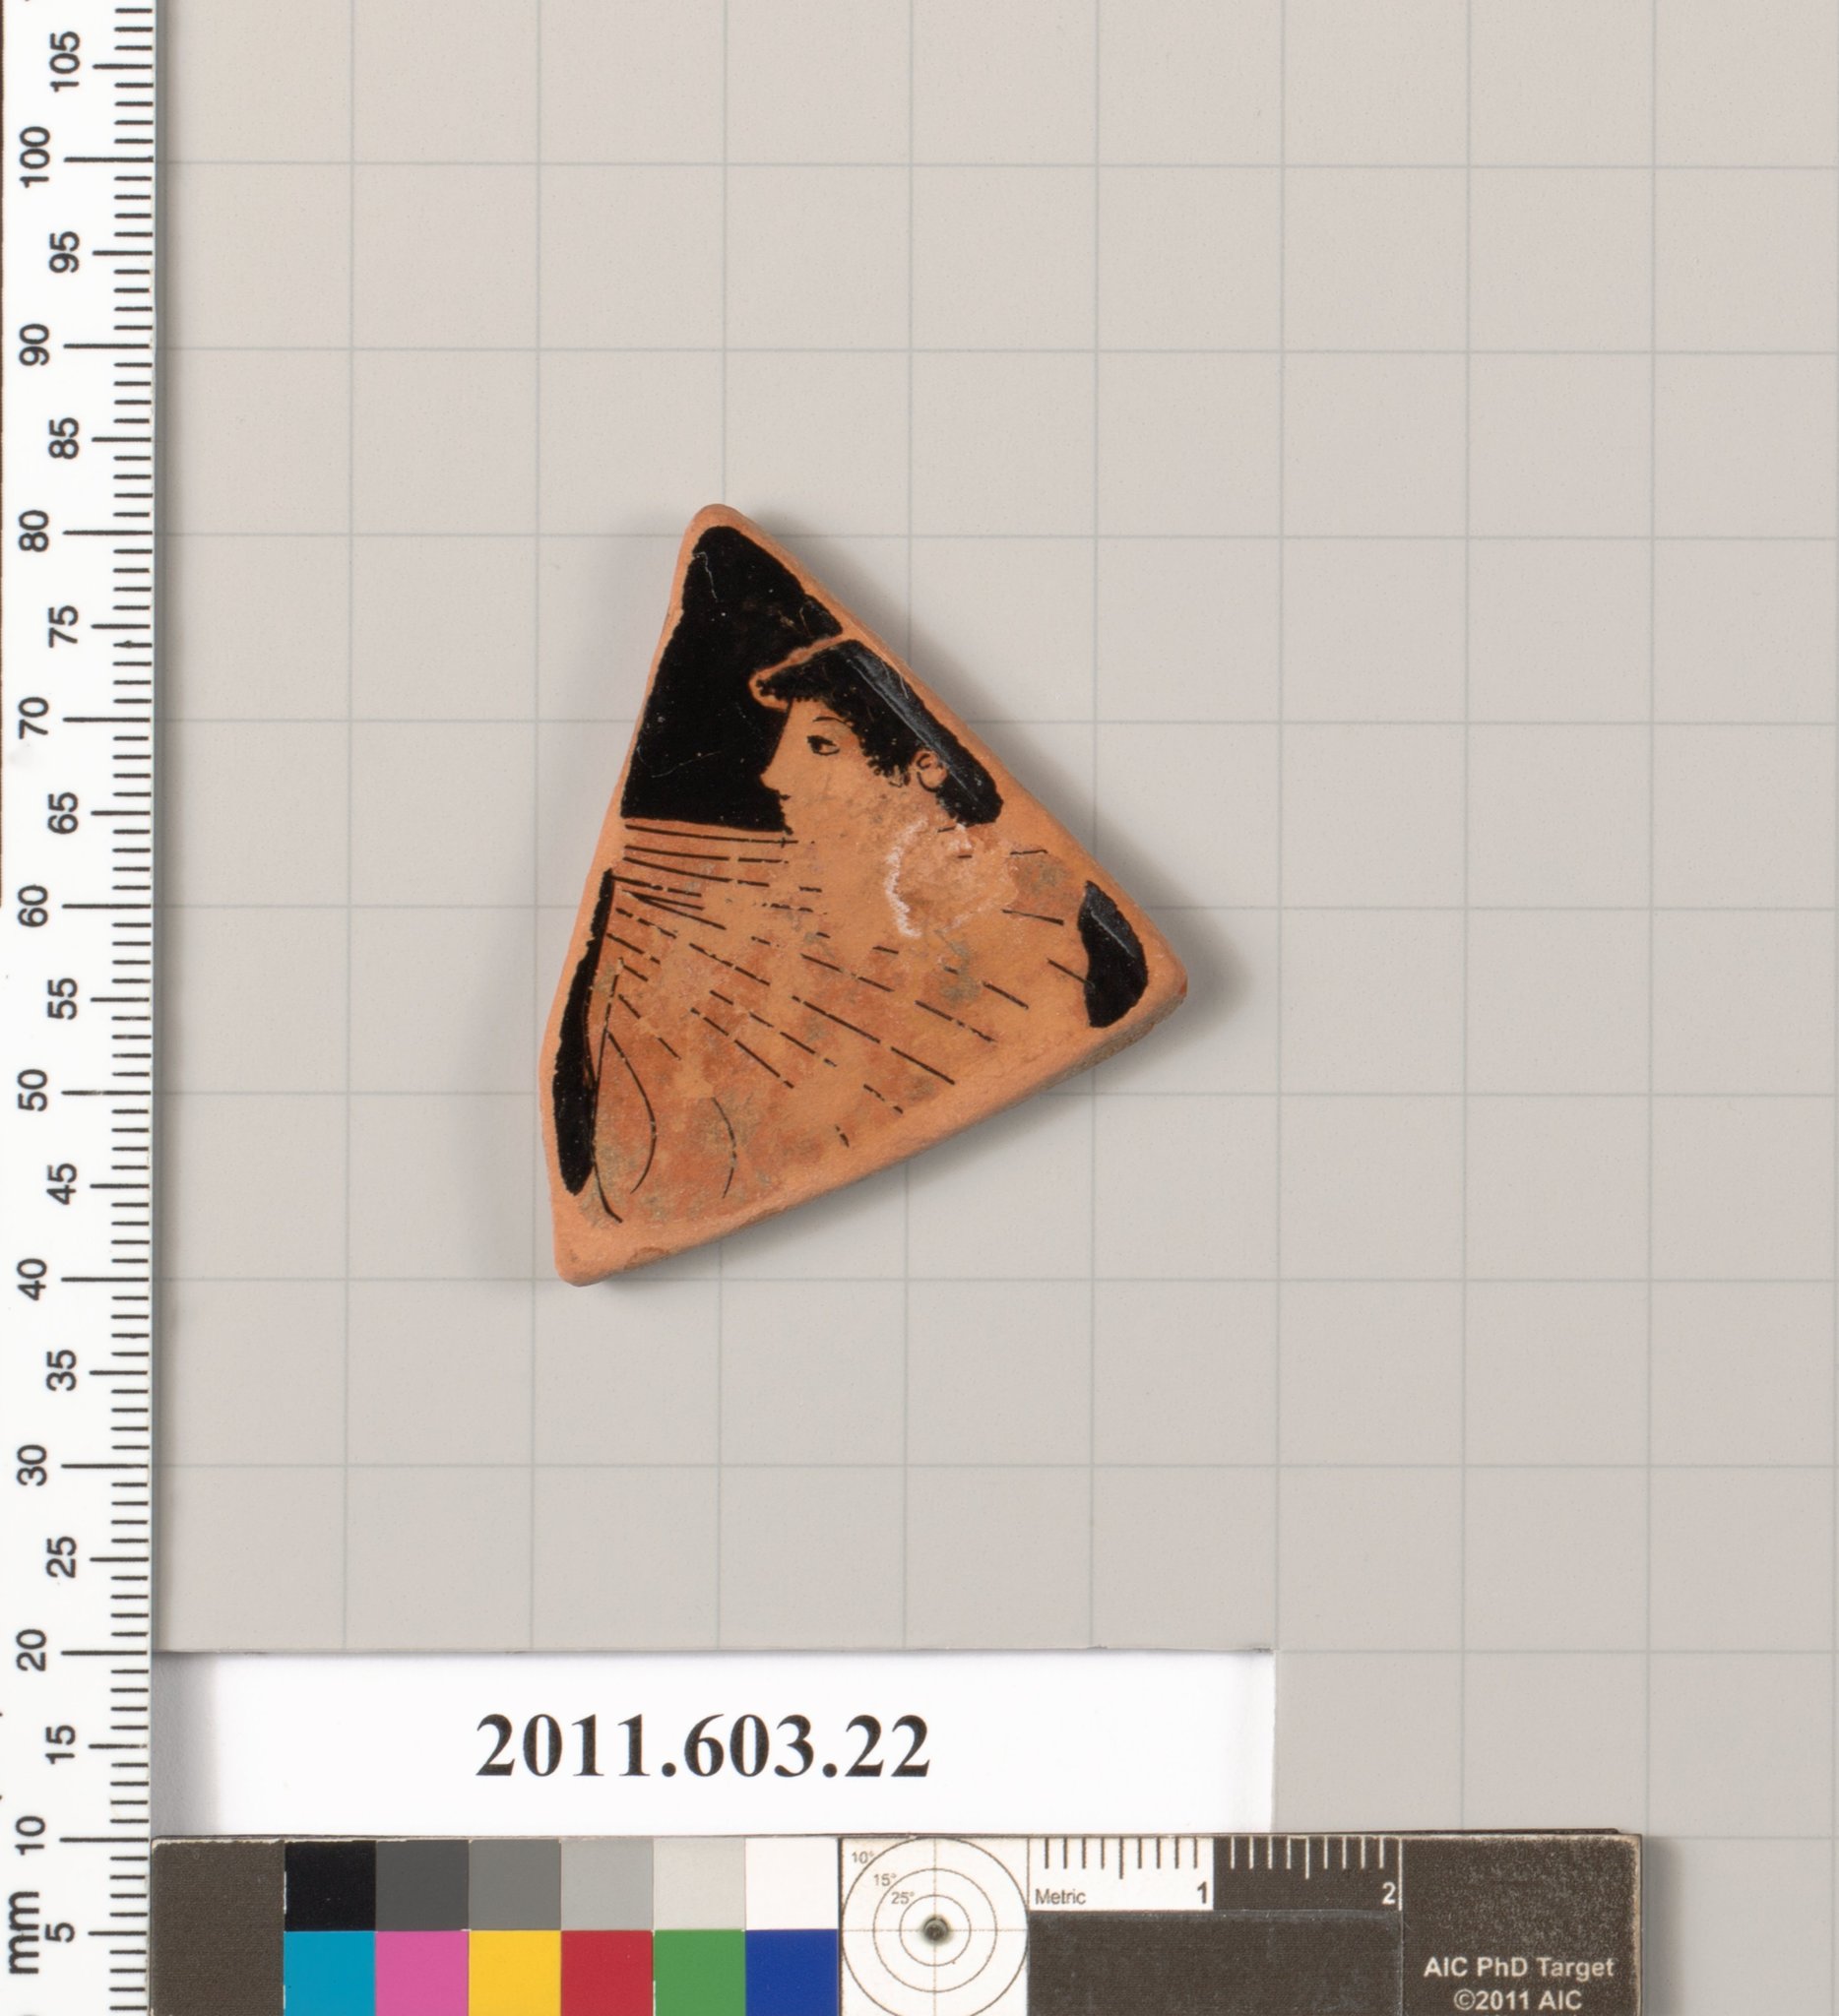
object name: kylix fragment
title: Fragment of a terracotta kylix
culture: greek, attic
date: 490-480 BCE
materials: terracotta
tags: heads